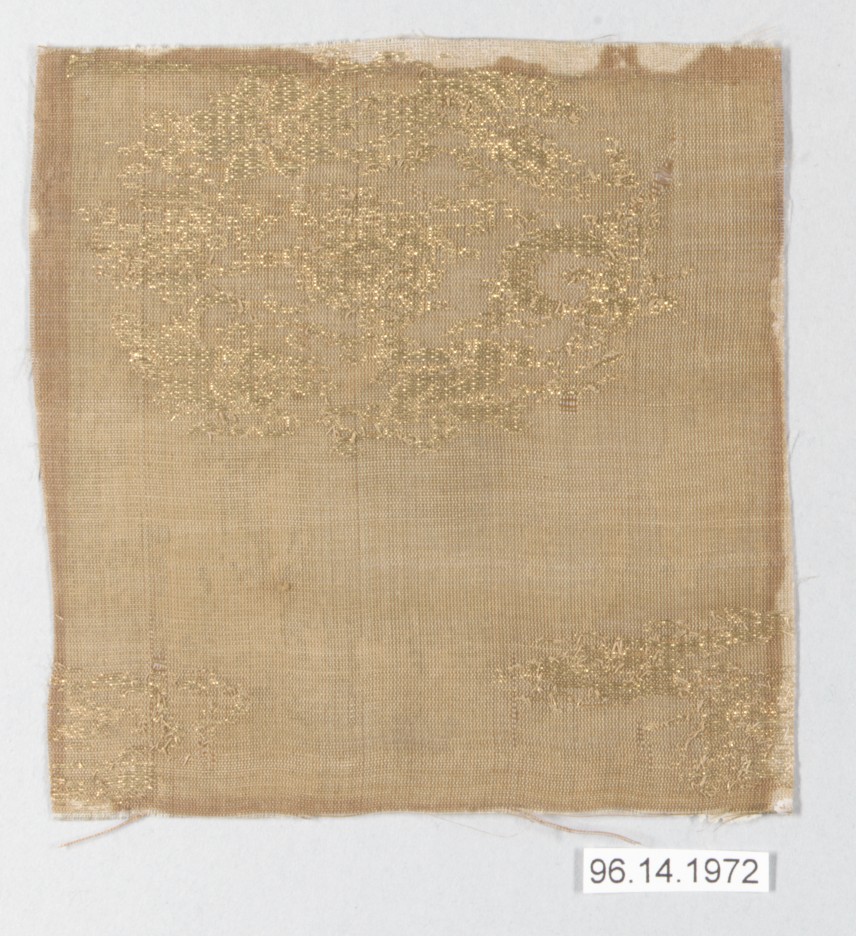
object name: piece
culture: japanese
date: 1801-1900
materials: metal thread, silk